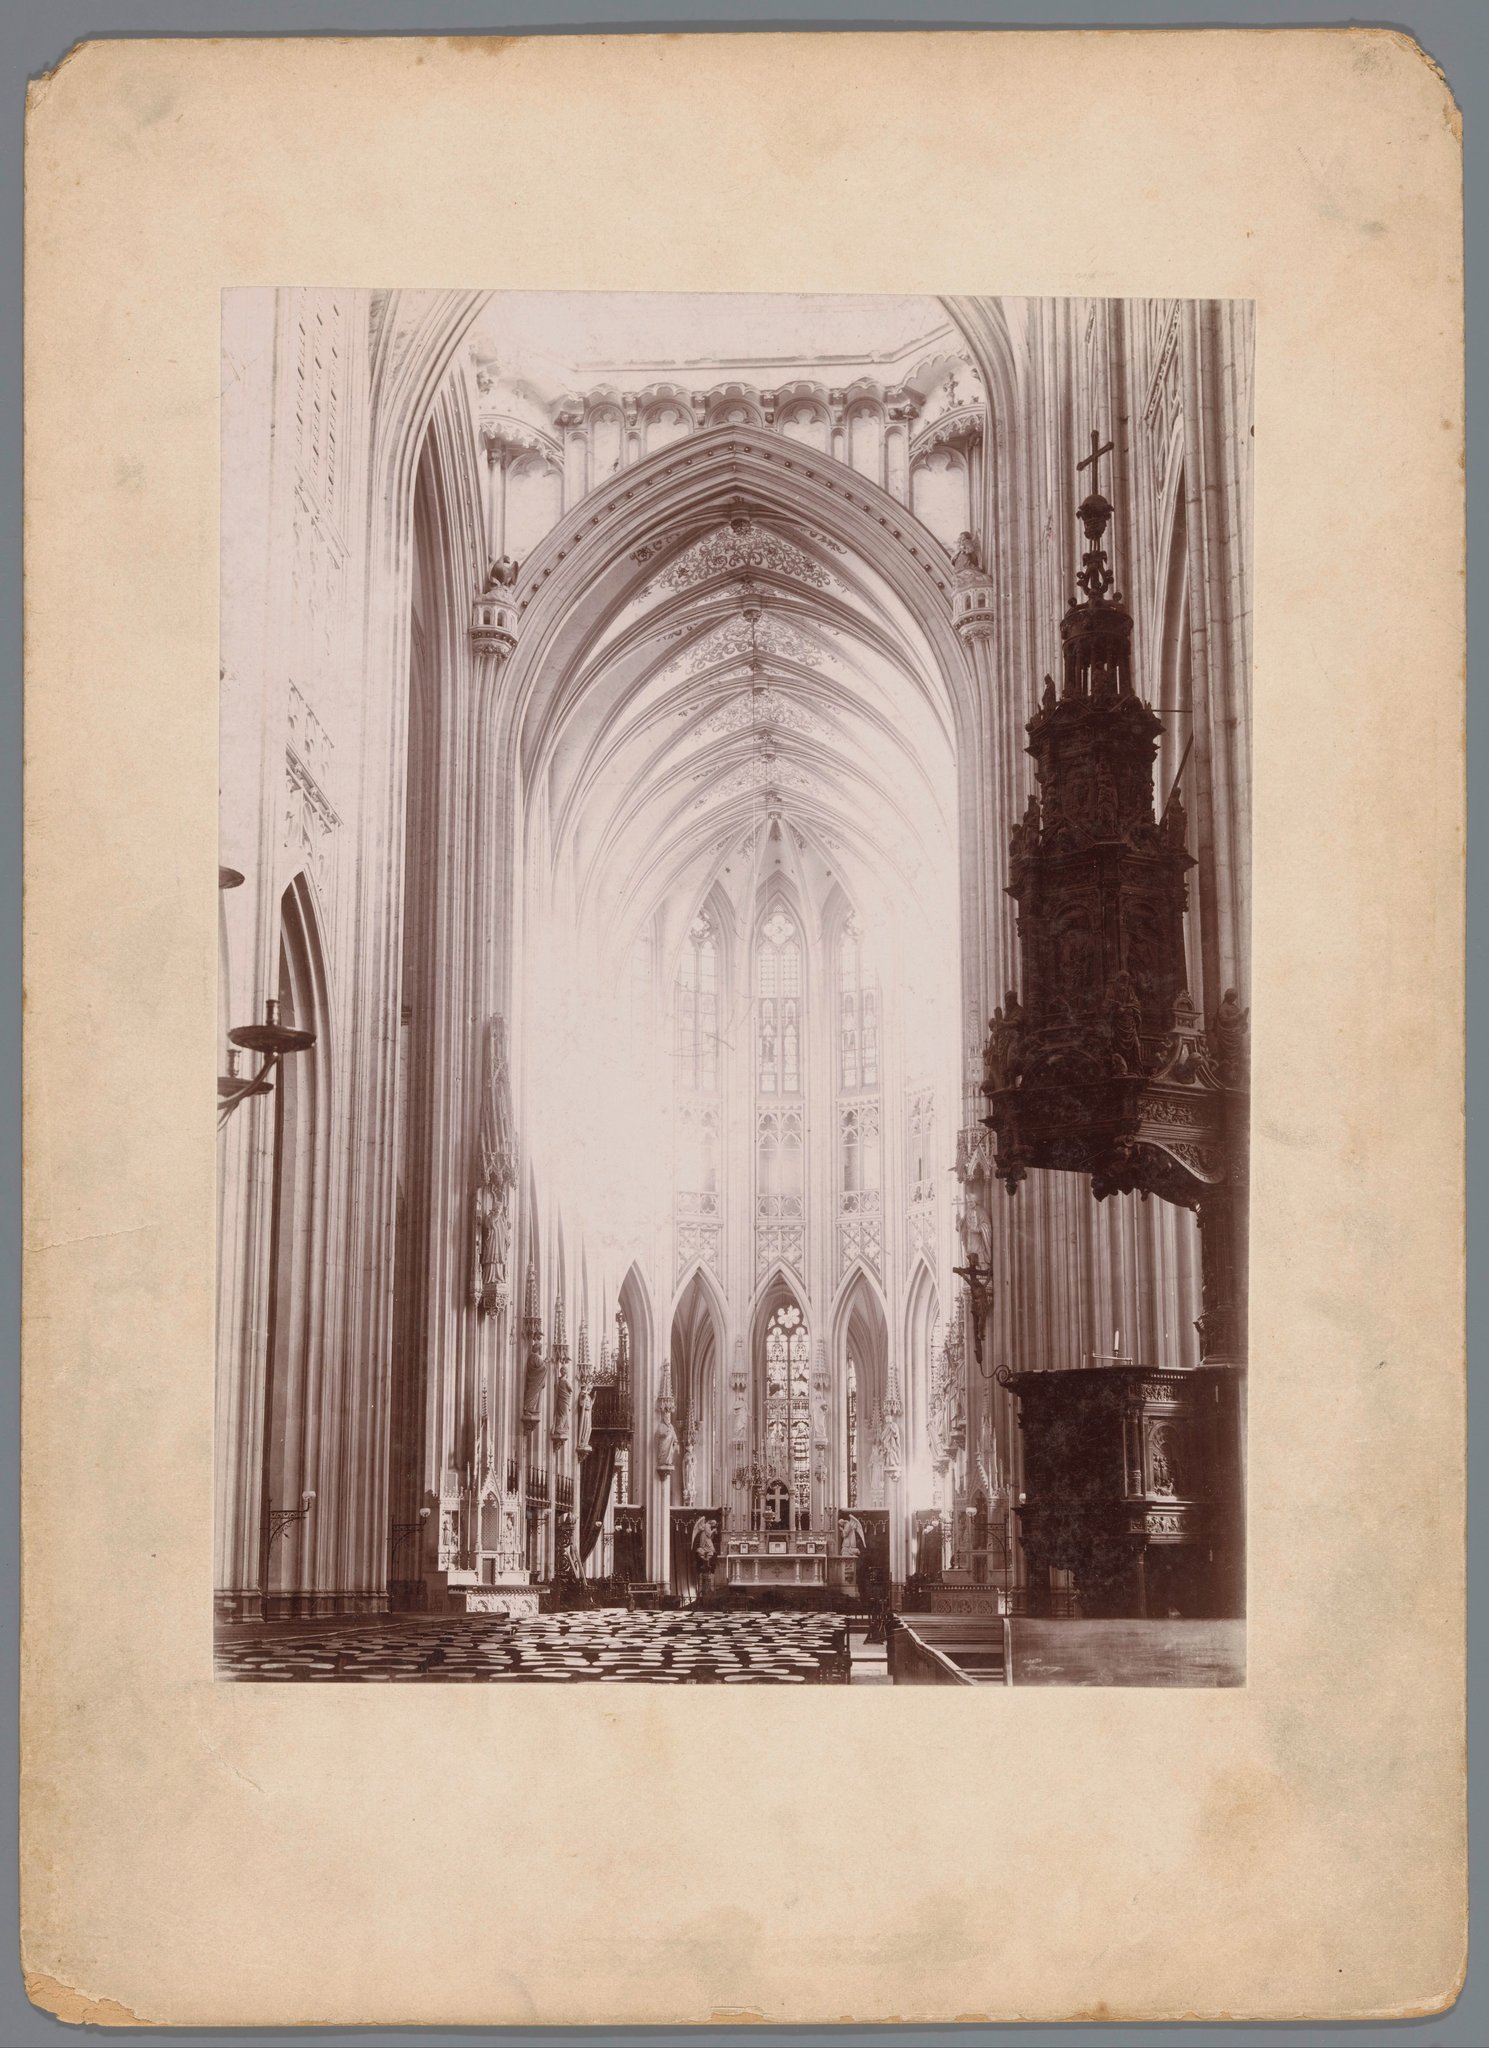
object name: photograph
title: Interieur van de Sint-Janskathedraal in Den Bosch, gezien richting koor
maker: Anonymous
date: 1875-1900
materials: cardboard, photographic support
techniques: daylight paper print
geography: sint-janskathedraal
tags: roman catholic church, parts of church interior: nave, pulpit, ambo, chancel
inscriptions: collector's mark: Lugt 3937, inscription: ‘S Janskerk te d. Bosch. gezicht in het koor’